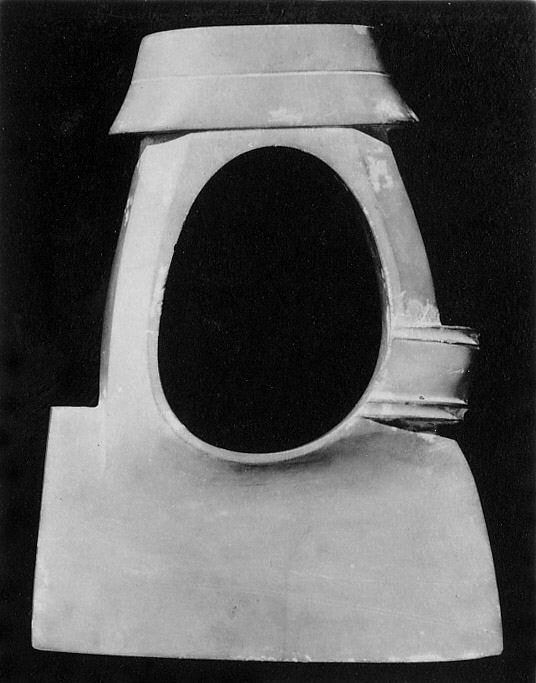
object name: bracelet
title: Hoe-shaped bracelet (kuwagataishi)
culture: japanese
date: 301-400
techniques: carving